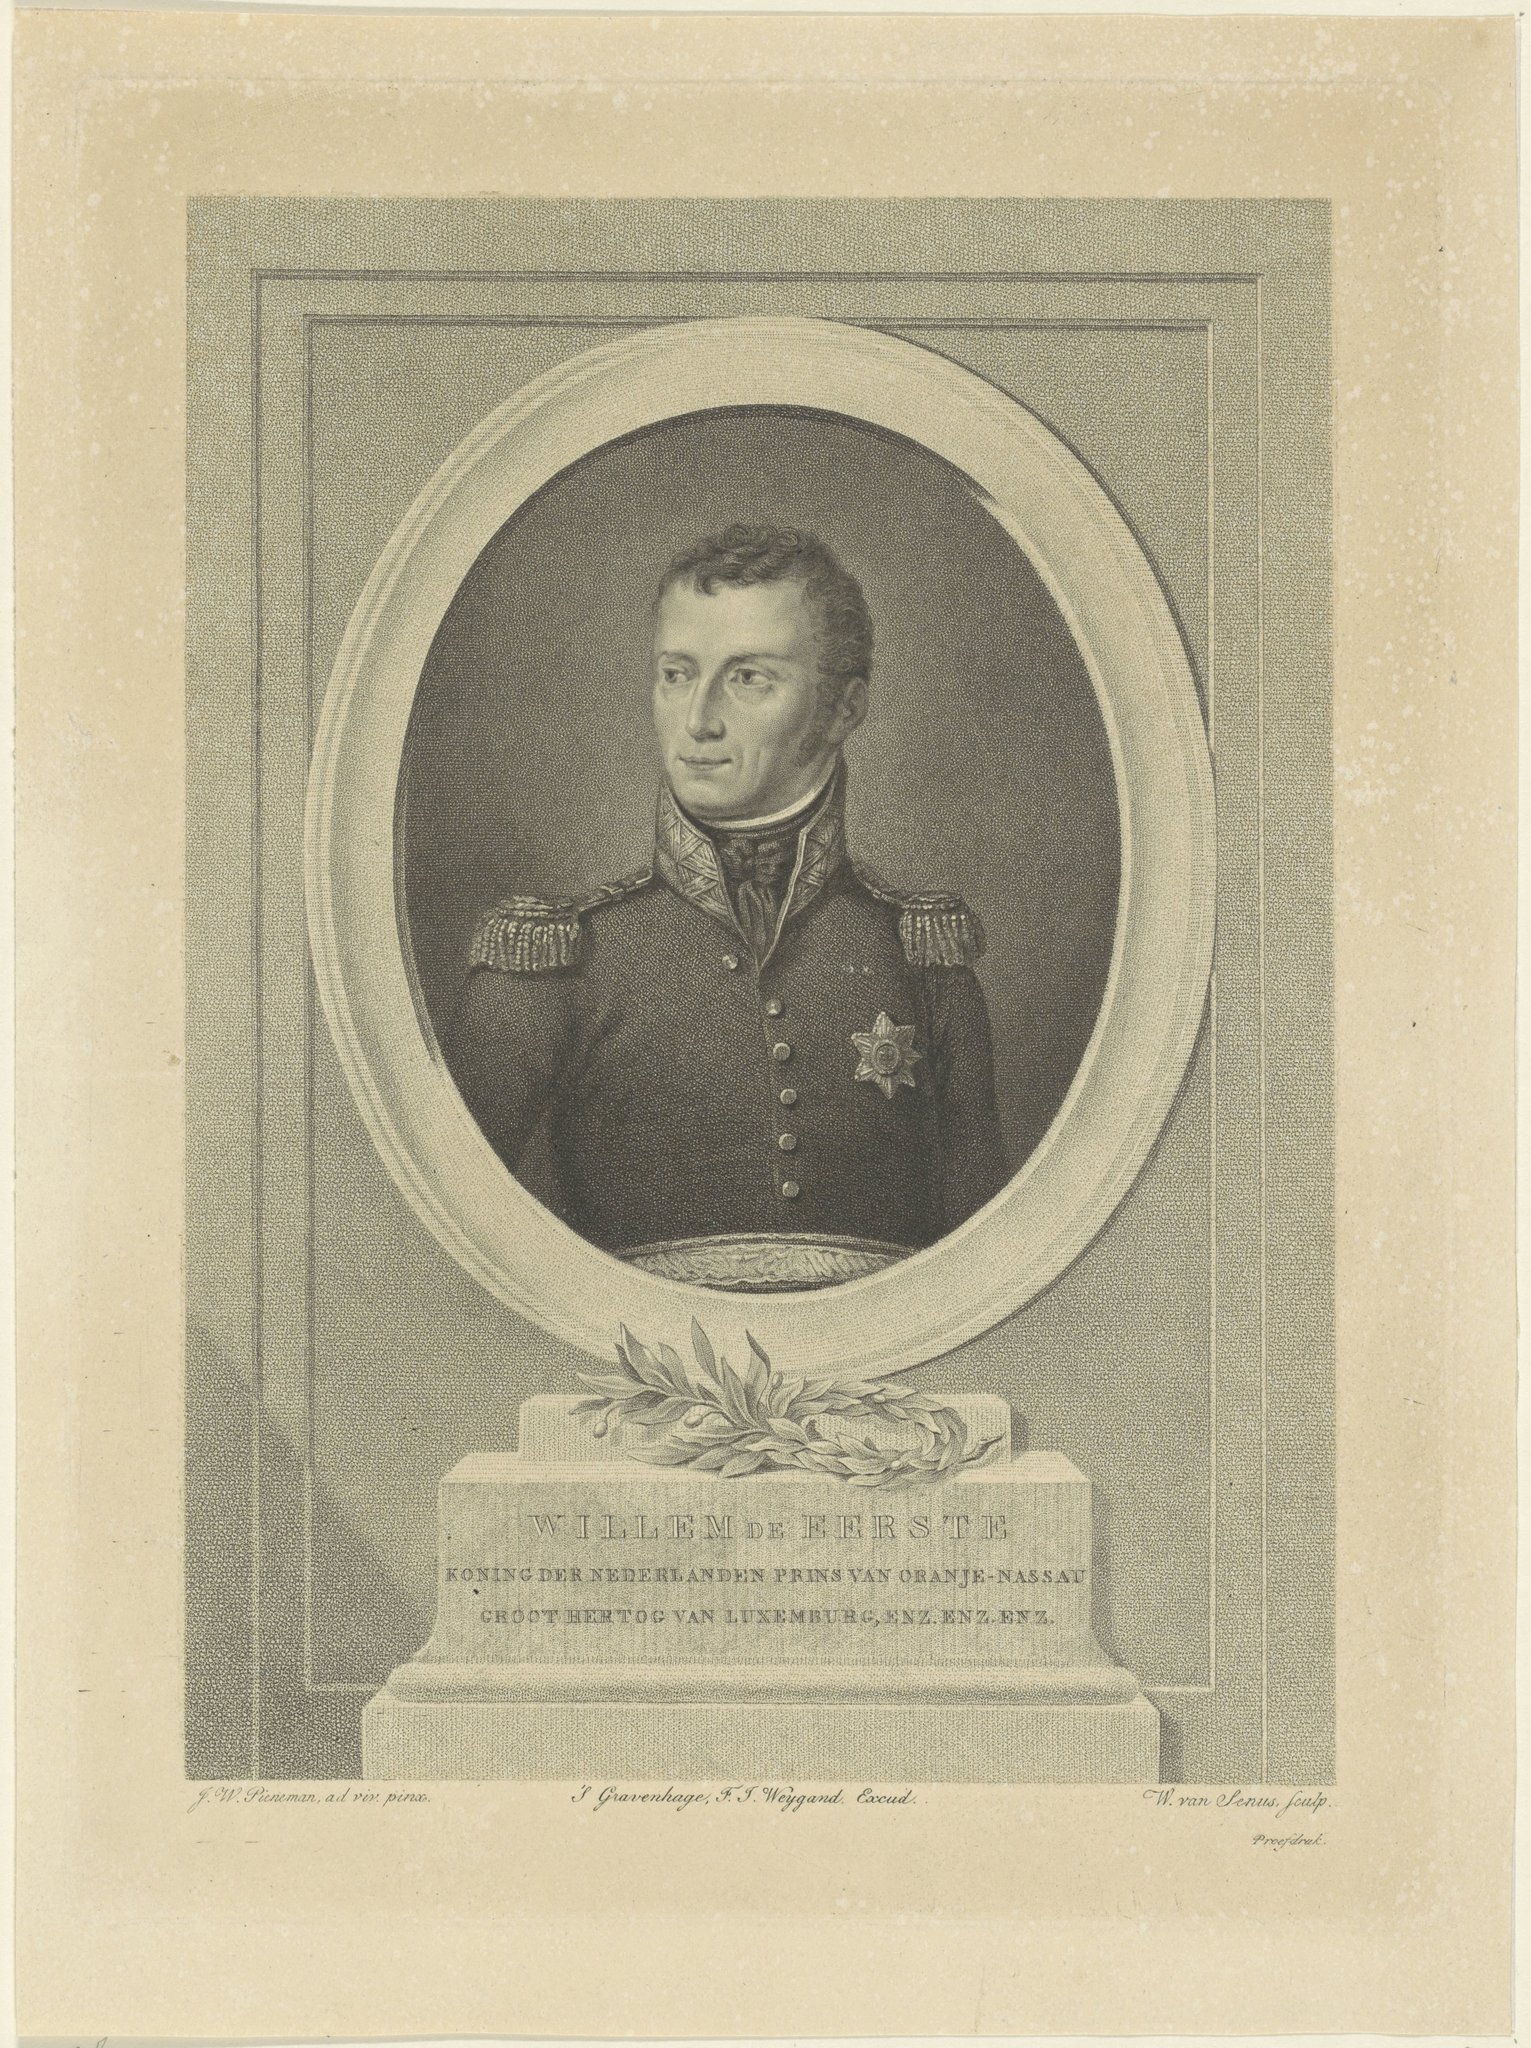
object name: print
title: Portret van Willem I Frederik, koning der Nederlanden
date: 1823-1839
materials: paper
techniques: engraving, etching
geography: the hague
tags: the hague, berlin, william i of the netherlands, knighthood order (with name) - insignia of a knighthood order, e.g.: badge, chain (with name of order)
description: De hier vermelde titel verwijst naar de hoogst verkregen titel van de geportretteerde, niet per se naar de titel die de geportretteerde op deze voorstelling draagt.